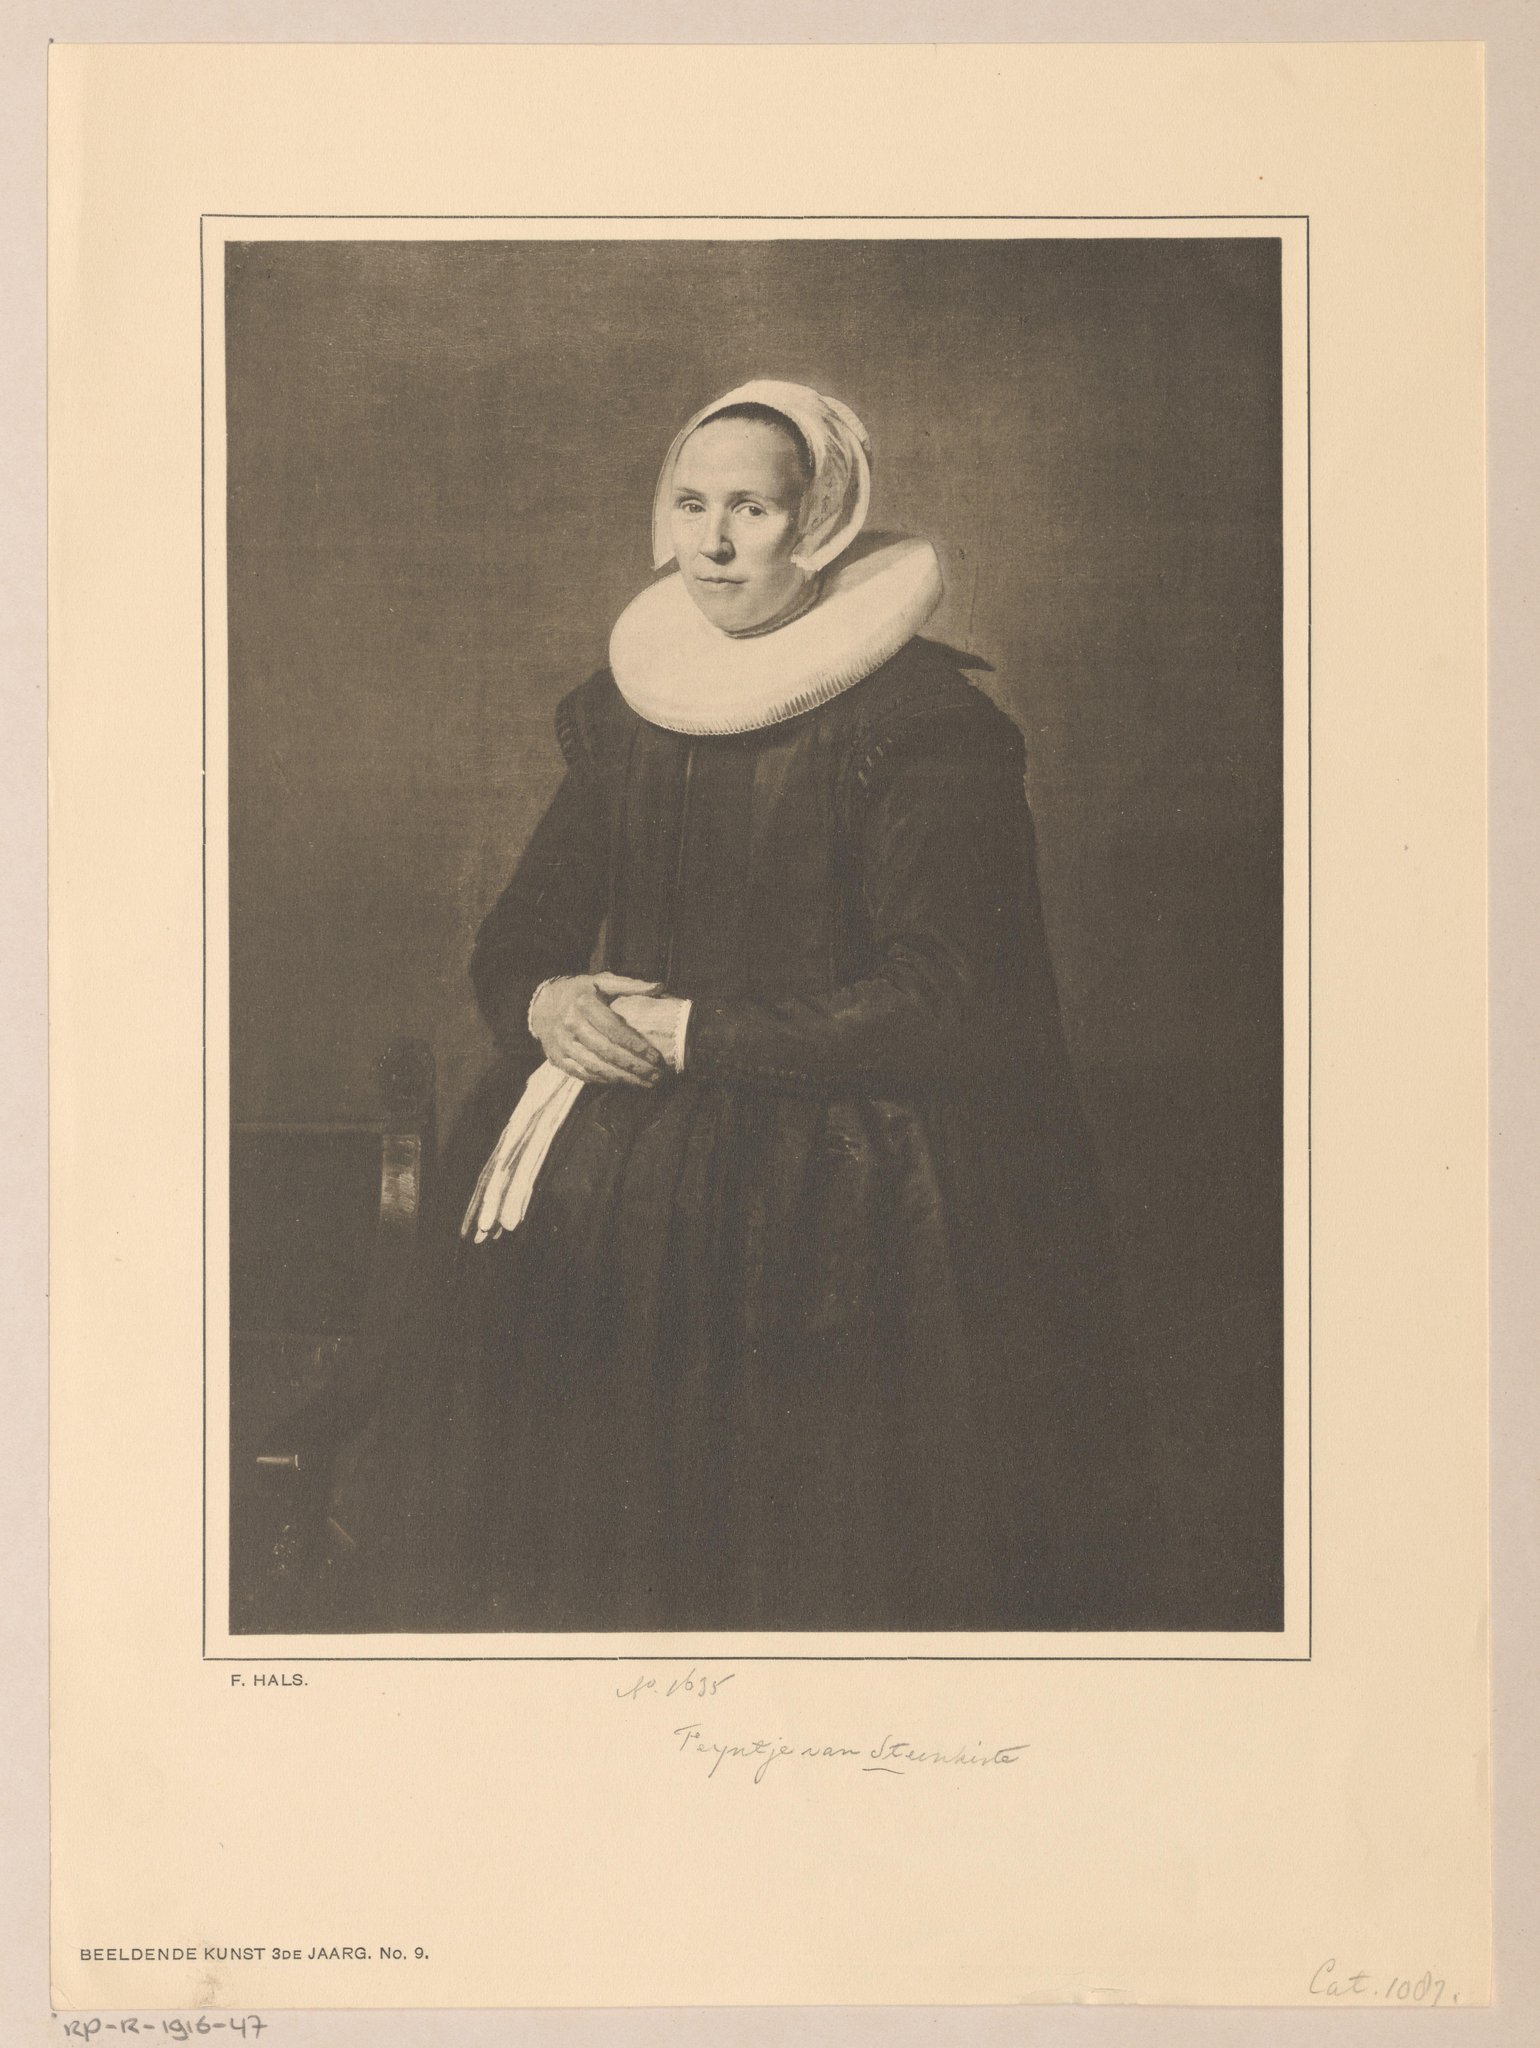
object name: photomechanical print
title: Portret van Feyntje van Steenkiste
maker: Anonymous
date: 1875-1930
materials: paper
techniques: photograph, letterpress printing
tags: haarlem, historical persons - bb - woman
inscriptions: collector's mark: Lugt 2228, inscription: ‘Ao. 1635 / Feyntje van Steenkiste / Cat. 1087.’